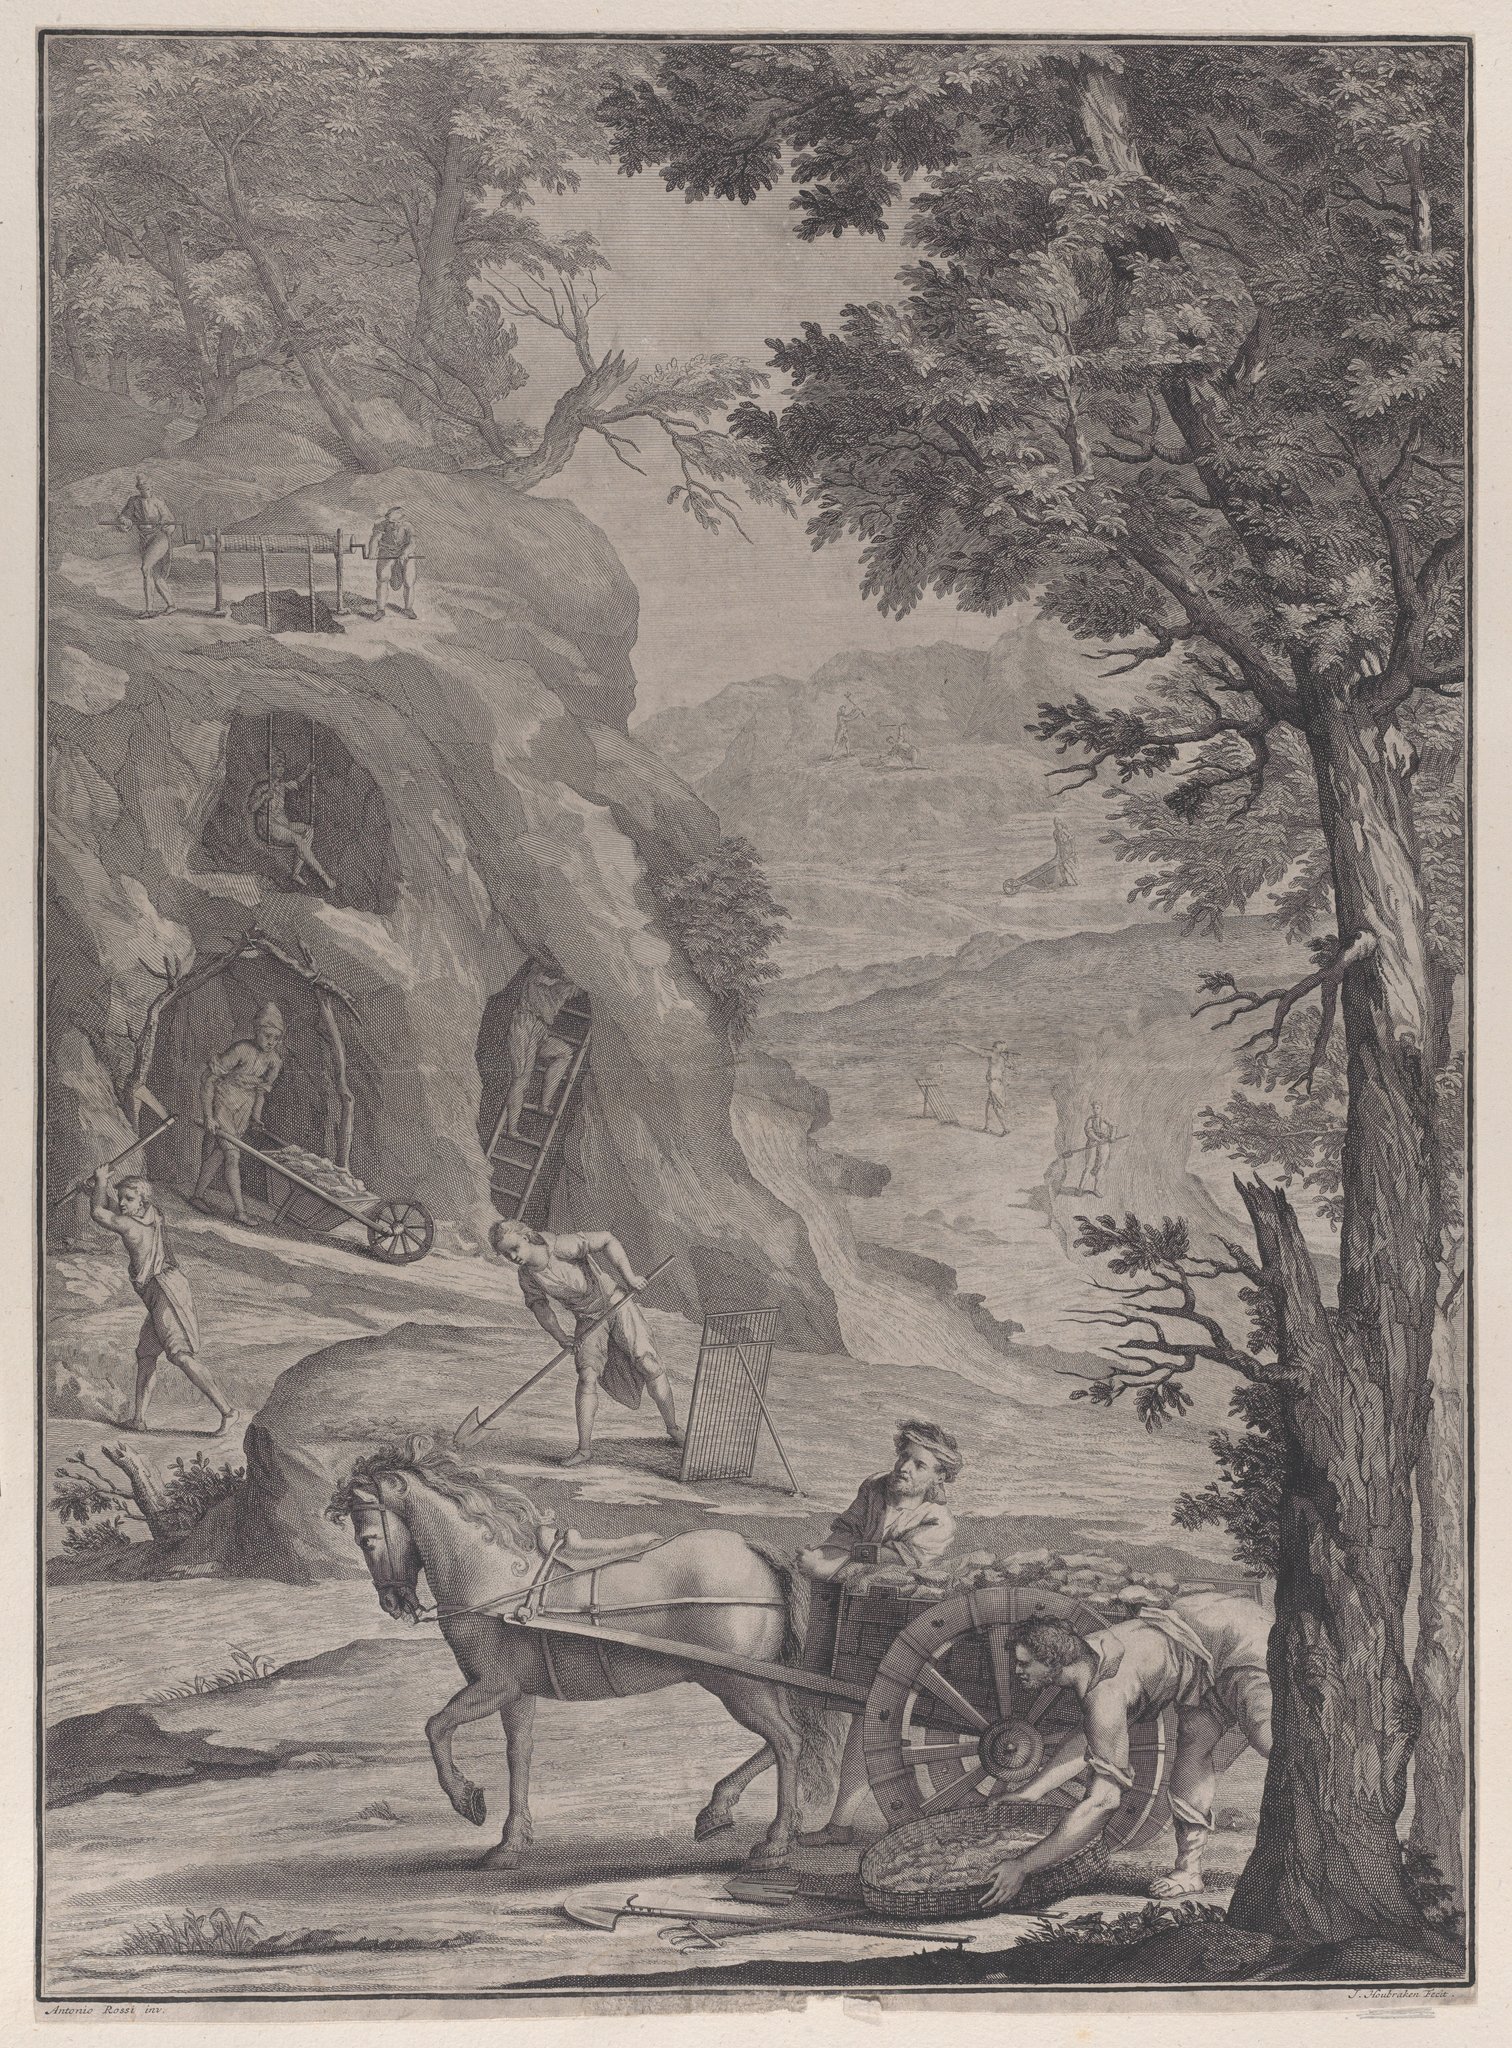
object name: print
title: Men quarrying or mining for gold, from 'Danubius Pannonico-Mysicus' (Volume 3)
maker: jacob houbraken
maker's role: artist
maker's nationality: dutch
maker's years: 1698-1780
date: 1726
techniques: etching